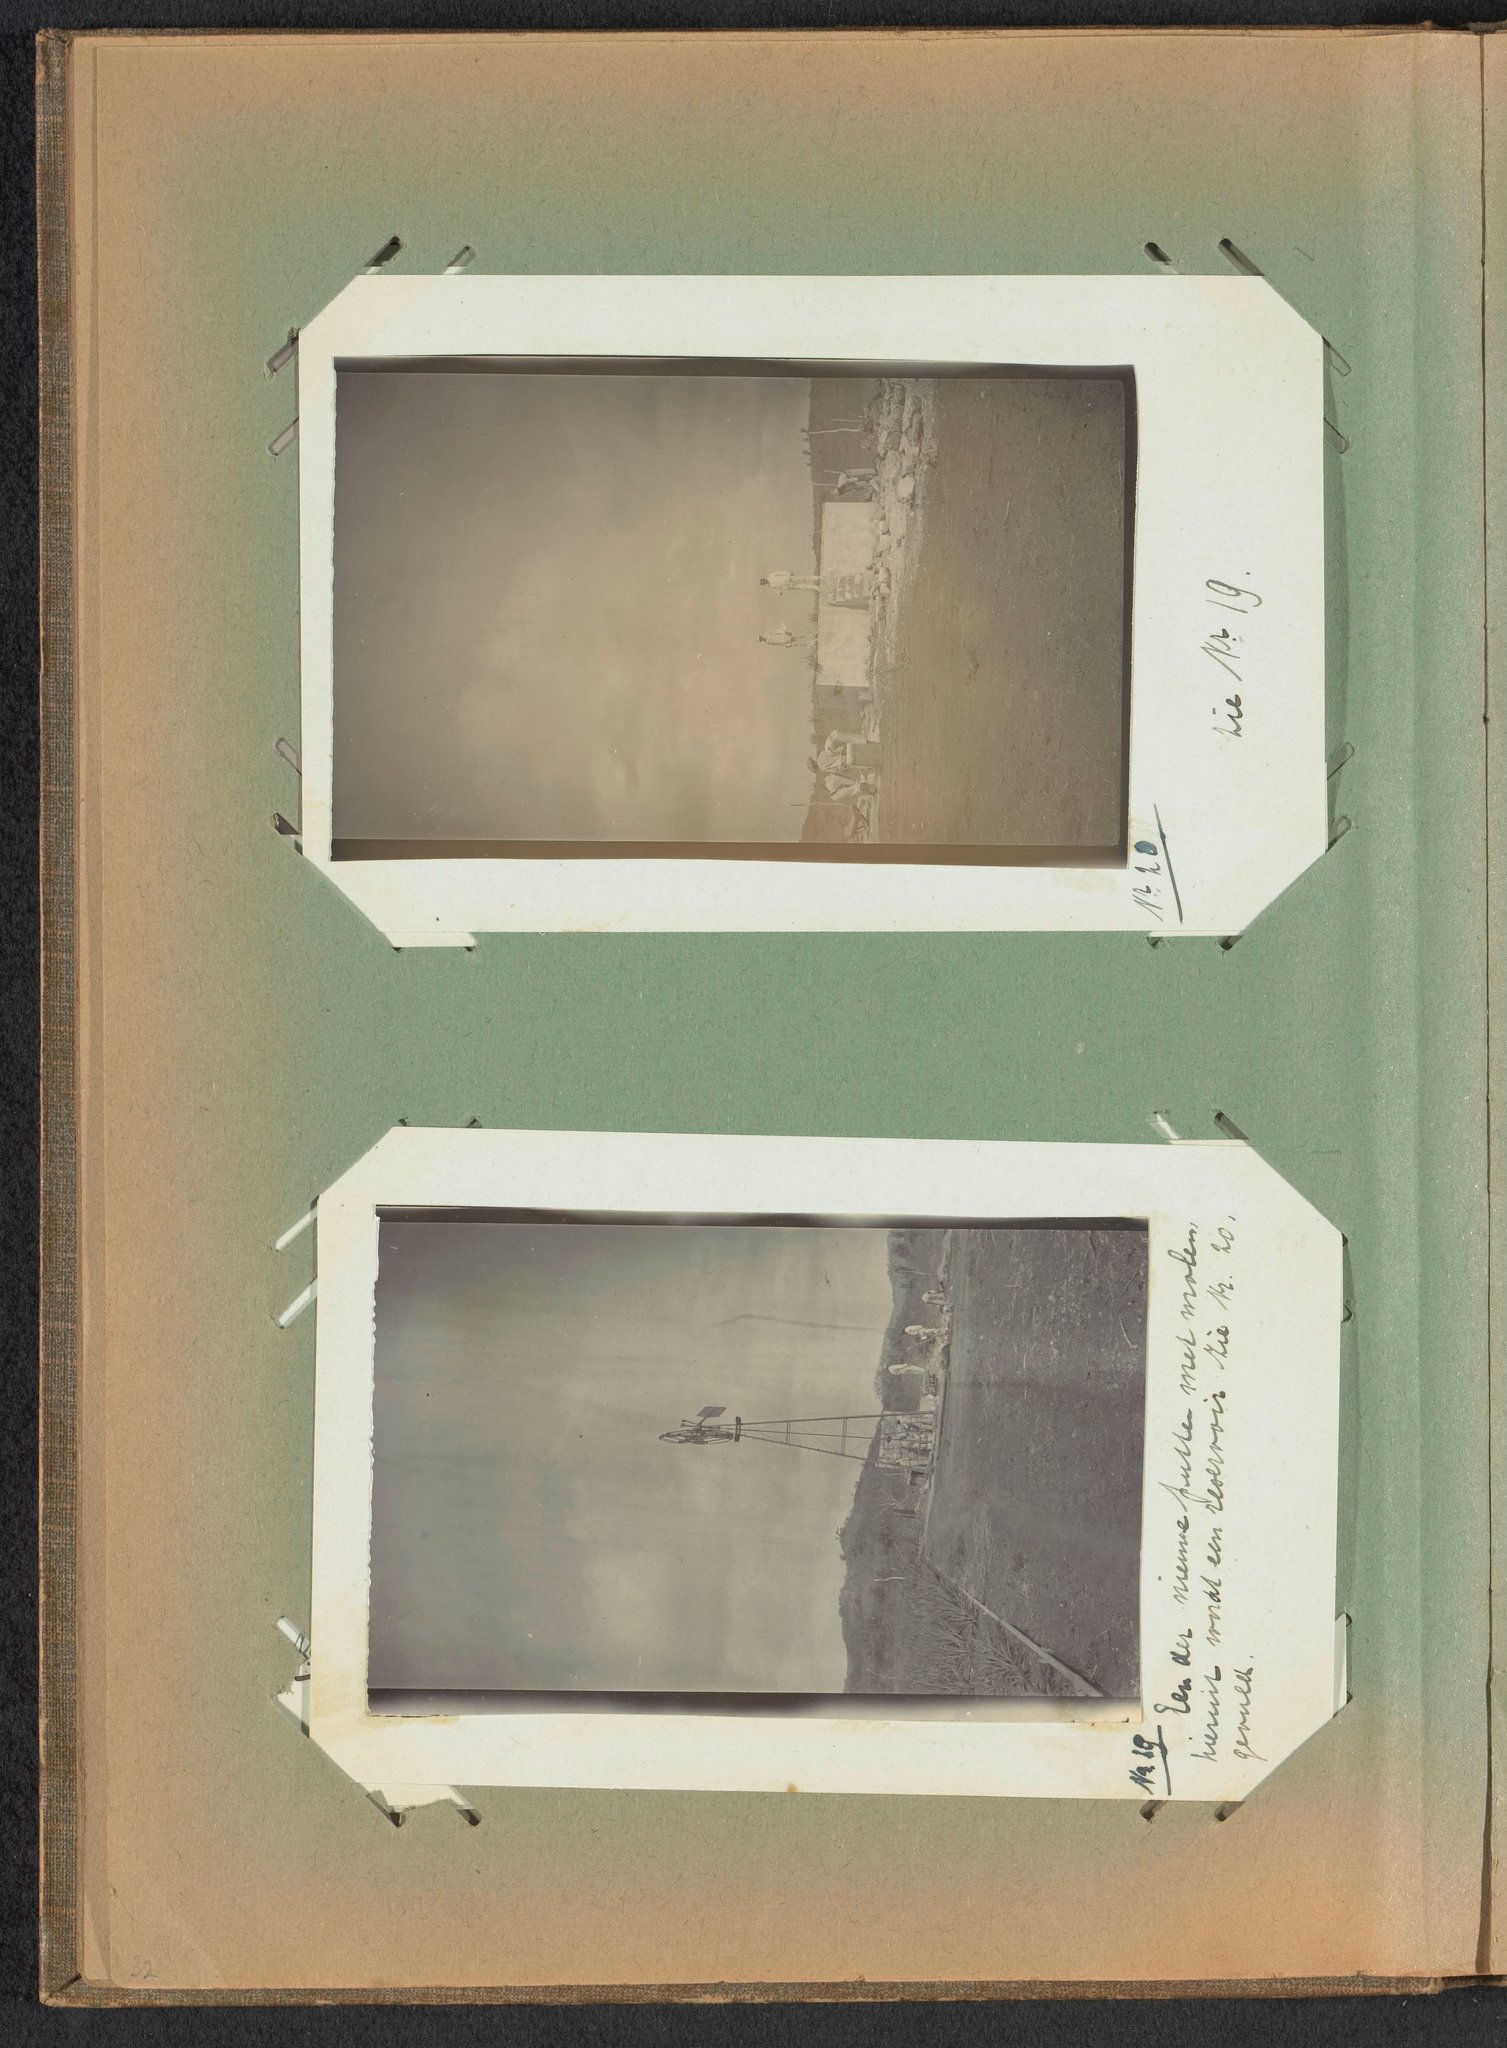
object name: photograph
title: Nr. 20 zie nr. 19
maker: Anonymous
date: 1912-1913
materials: paper, photographic support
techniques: gelatin silver print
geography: curacao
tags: plantation, windmill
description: Bouw van de reservoir. Bij Plantage Mount Pleasant op Curaçao. Onderdeel van het fotoalbum uit ca. 1912-1913 met 92 foto's van de plantages Peperpot en Dordrecht in Suriname en Mount Pleasant op Curaçao.